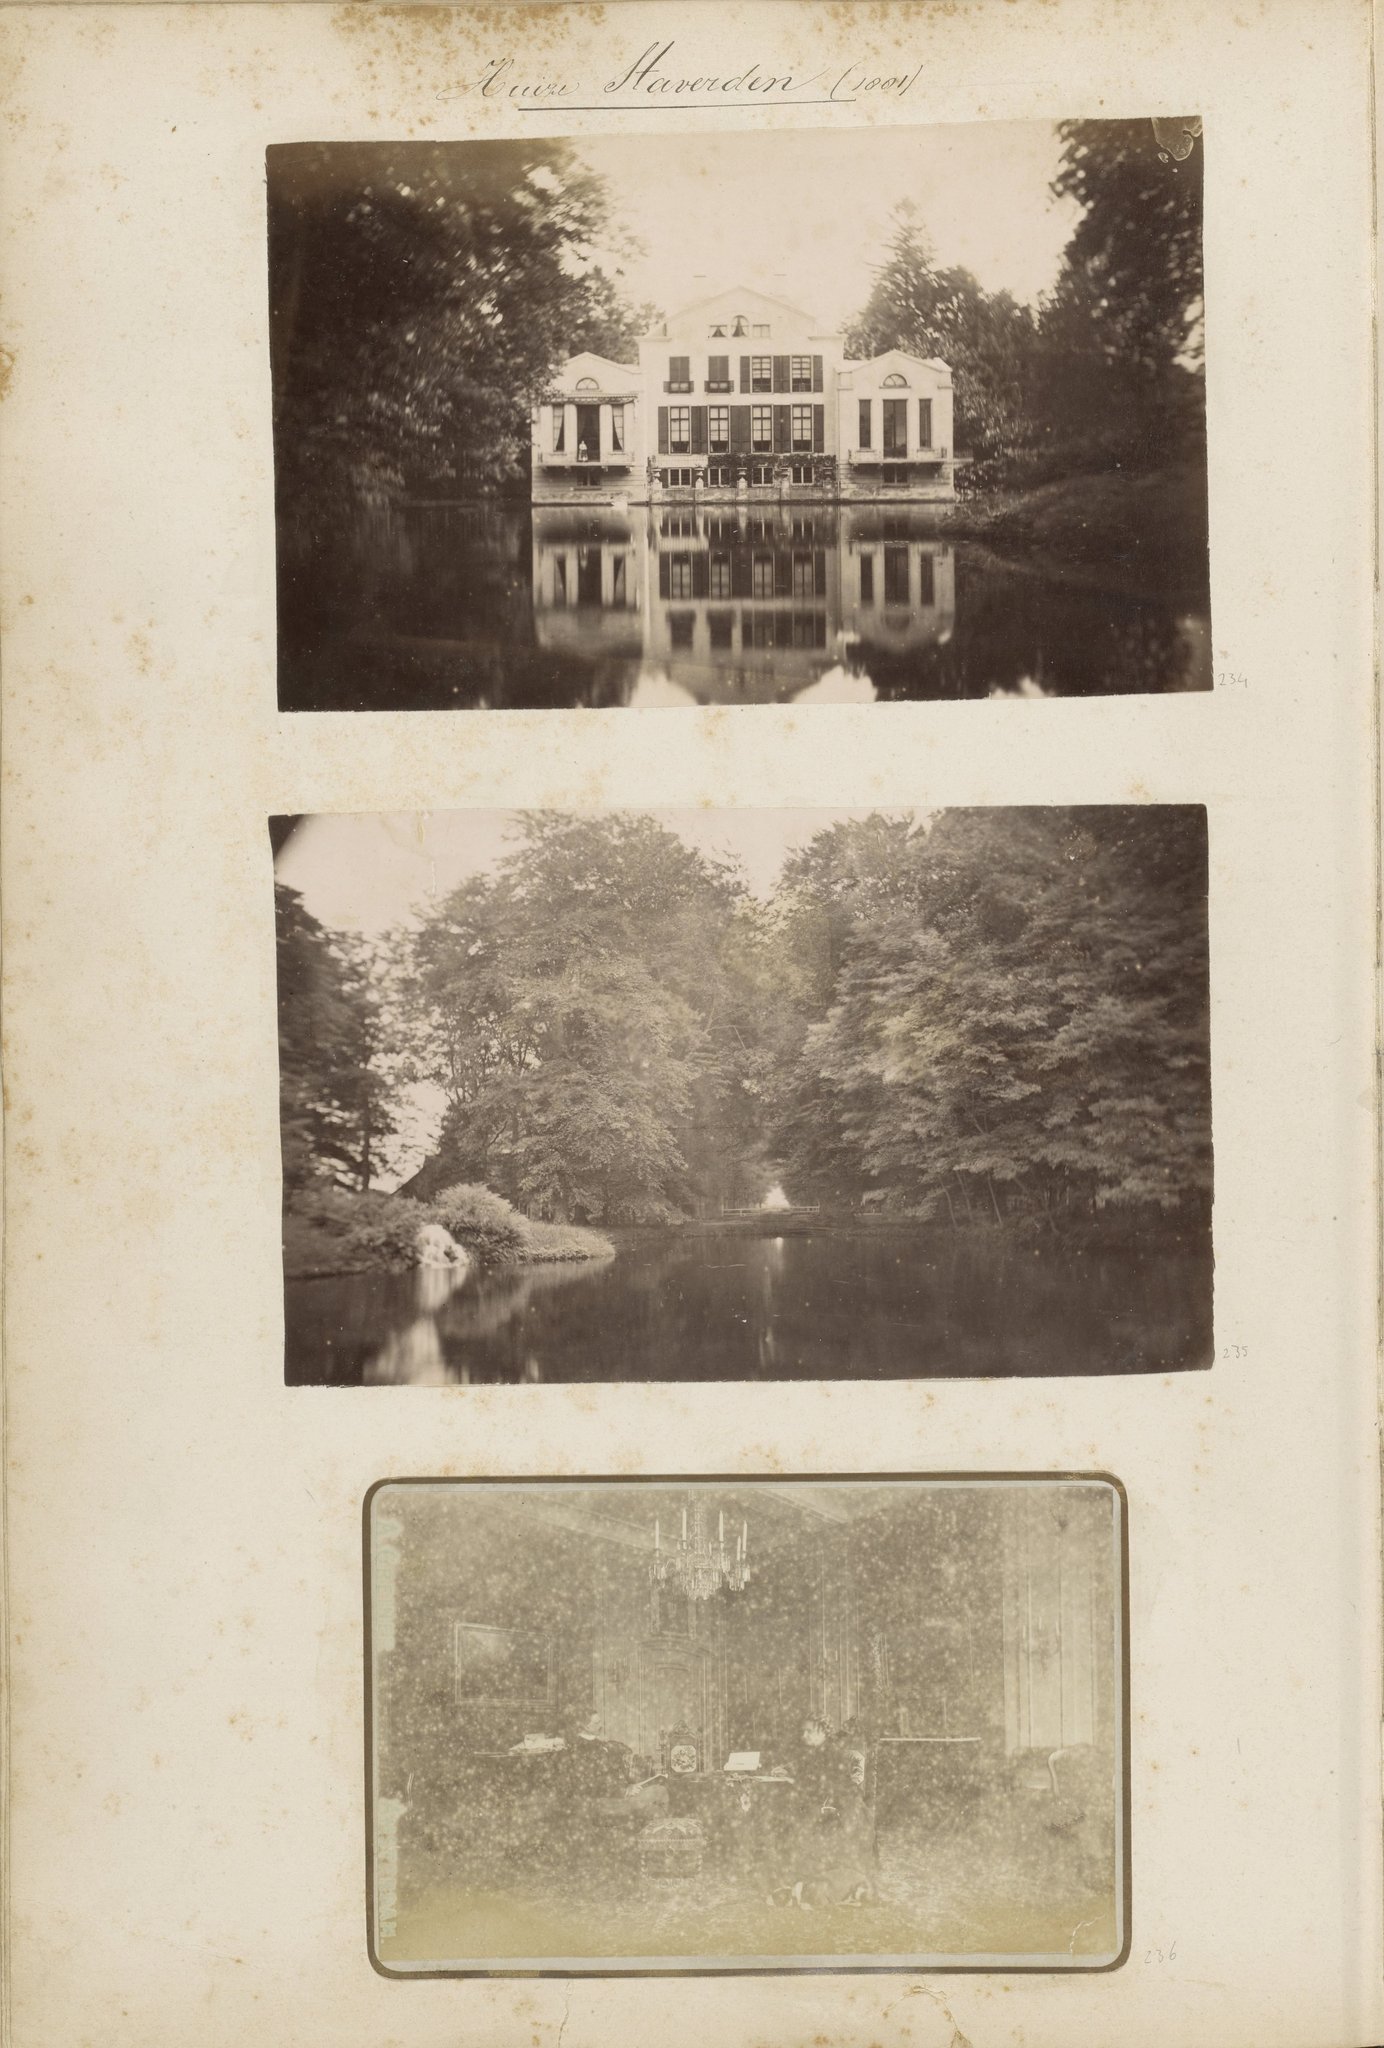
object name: album leaf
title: Man en een vrouw zittend in een woonkamer, vermoedelijk in kasteel Staverden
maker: Anonymous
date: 1881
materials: cardboard, paper, photographic support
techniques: albumen print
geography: staverden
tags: rural housing, e.g. country-house, villa, cottage, living-room, parlour, sitting-room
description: Onderdeel van Fotoalbum van Robert Daniel Crommelin (1841-1907).